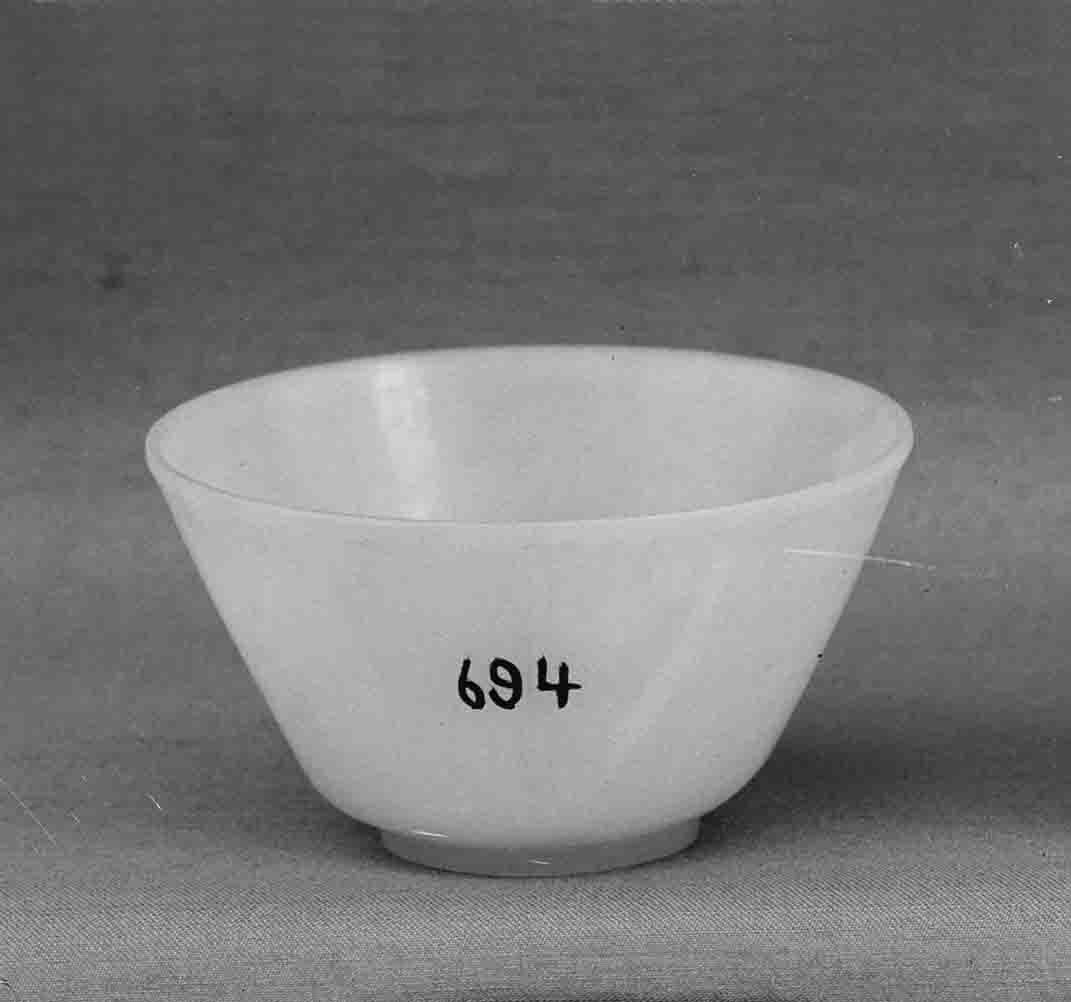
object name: wine cup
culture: chinese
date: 1736-1795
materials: jade